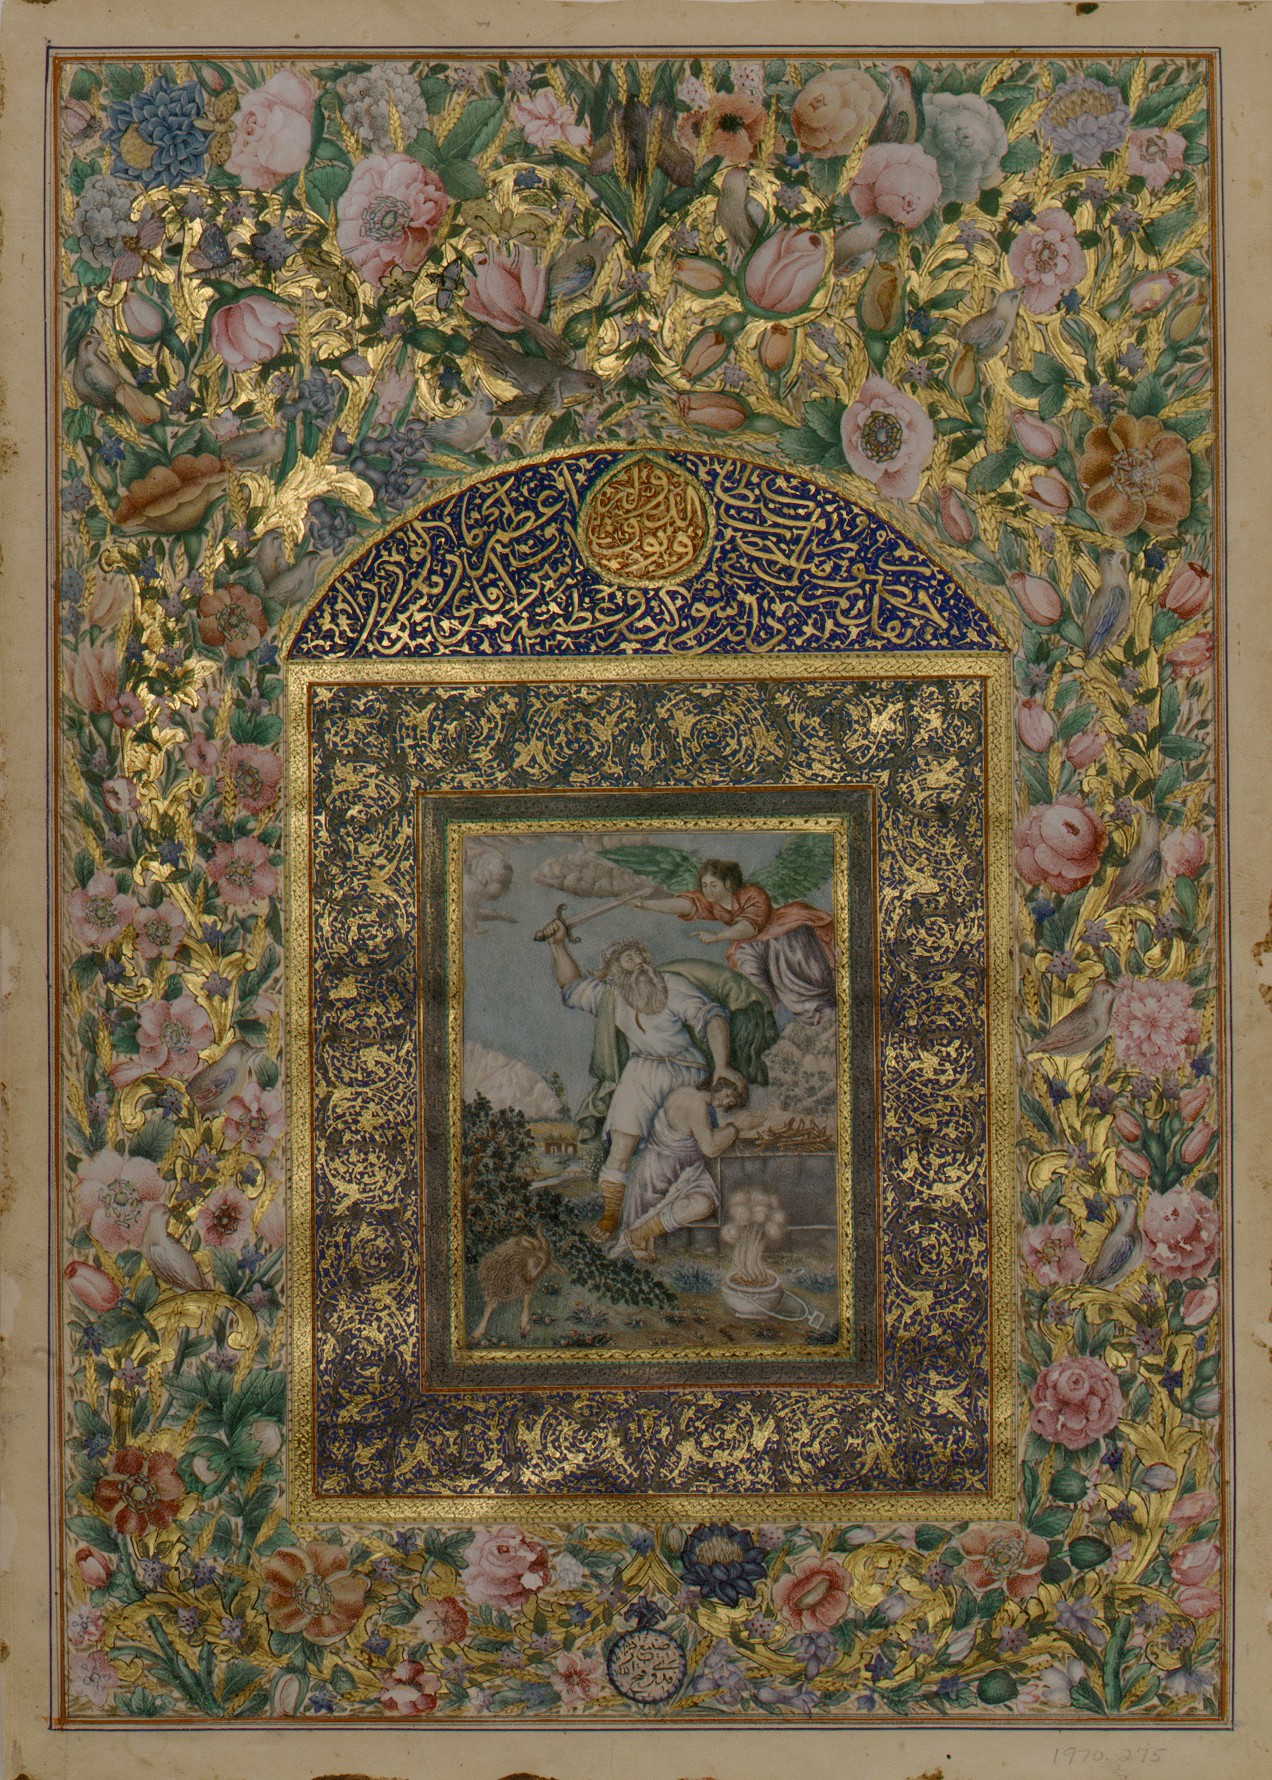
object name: illustrated single work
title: Abraham's Sacrifice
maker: fathallah sani'zada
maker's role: artist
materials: gold, ink, paper, watercolor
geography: iran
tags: birds,men,flowers,angels,abraham